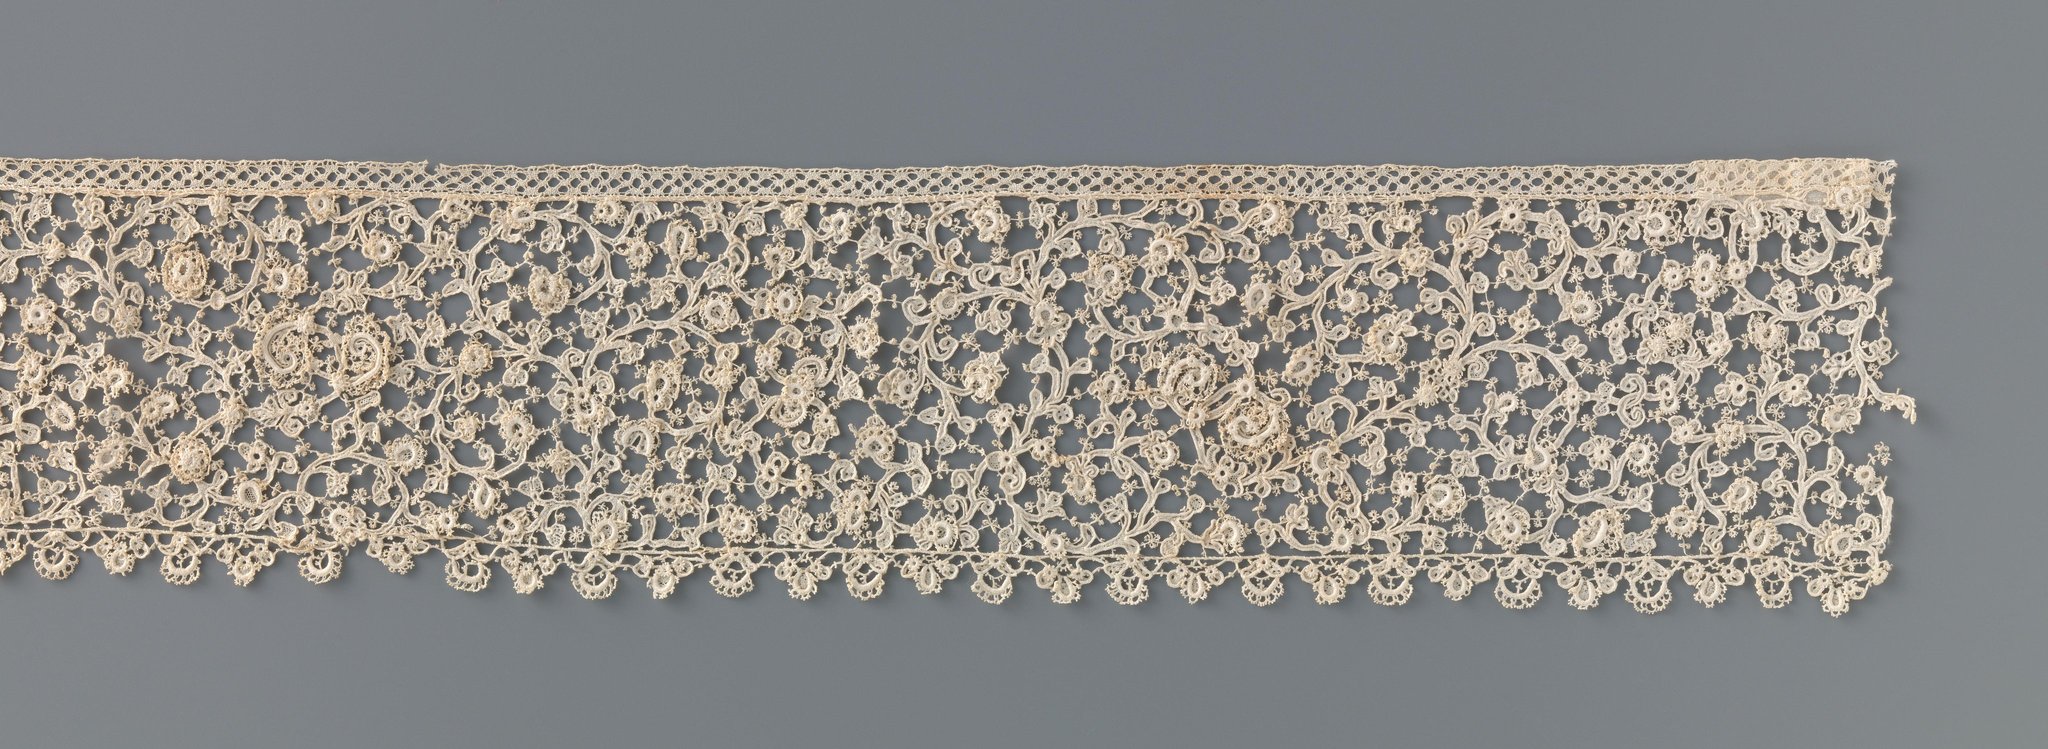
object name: strip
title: Band with Diverse Roses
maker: Anonymous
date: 1685-1699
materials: linen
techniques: rose point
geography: venice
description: Lace with small and refined, as well as large and imposing, motifs was made in Venice at the end of the 17th century. These are two variations of the first kind, the so-called Venetian raised and small scale lace. The French call it point de neige, literally snowflake stitch.